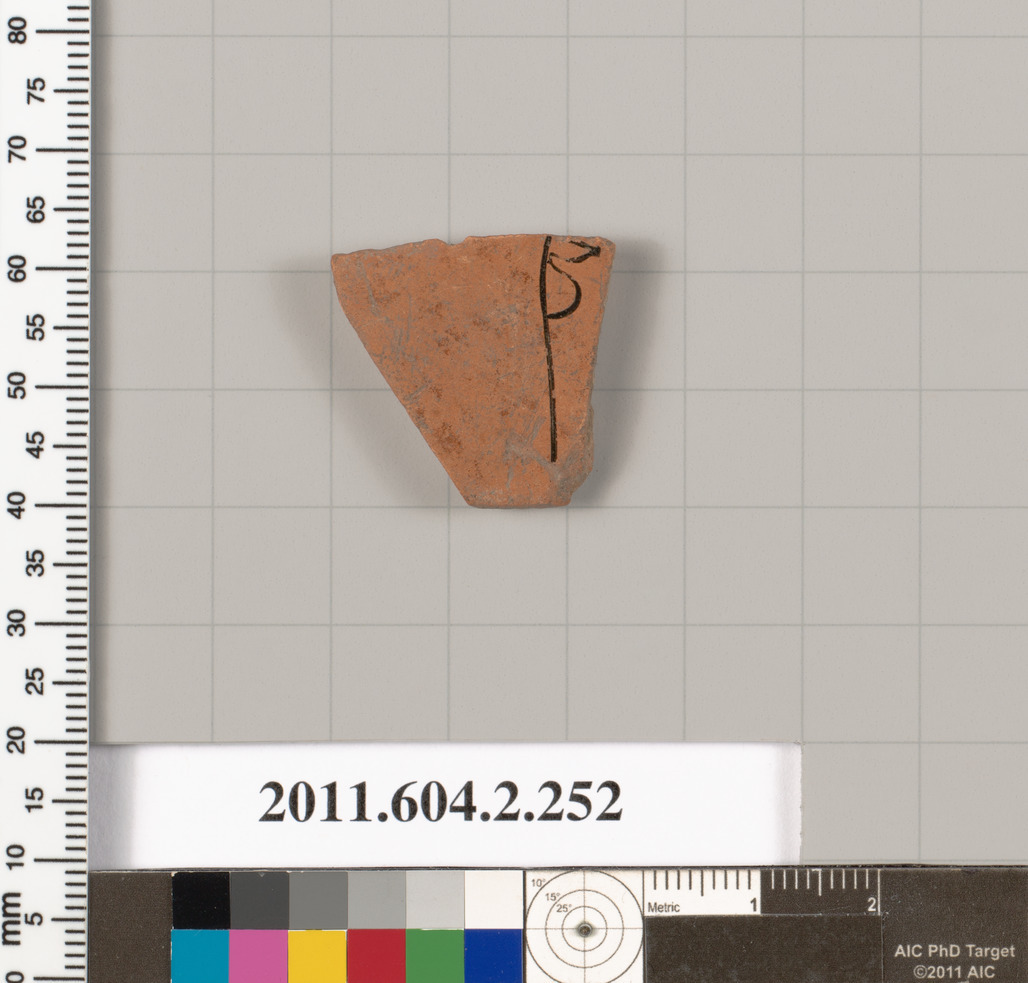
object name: stamnos fragment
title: Terracotta fragment of a stamnos (jar)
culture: greek, attic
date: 490-480 BCE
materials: terracotta